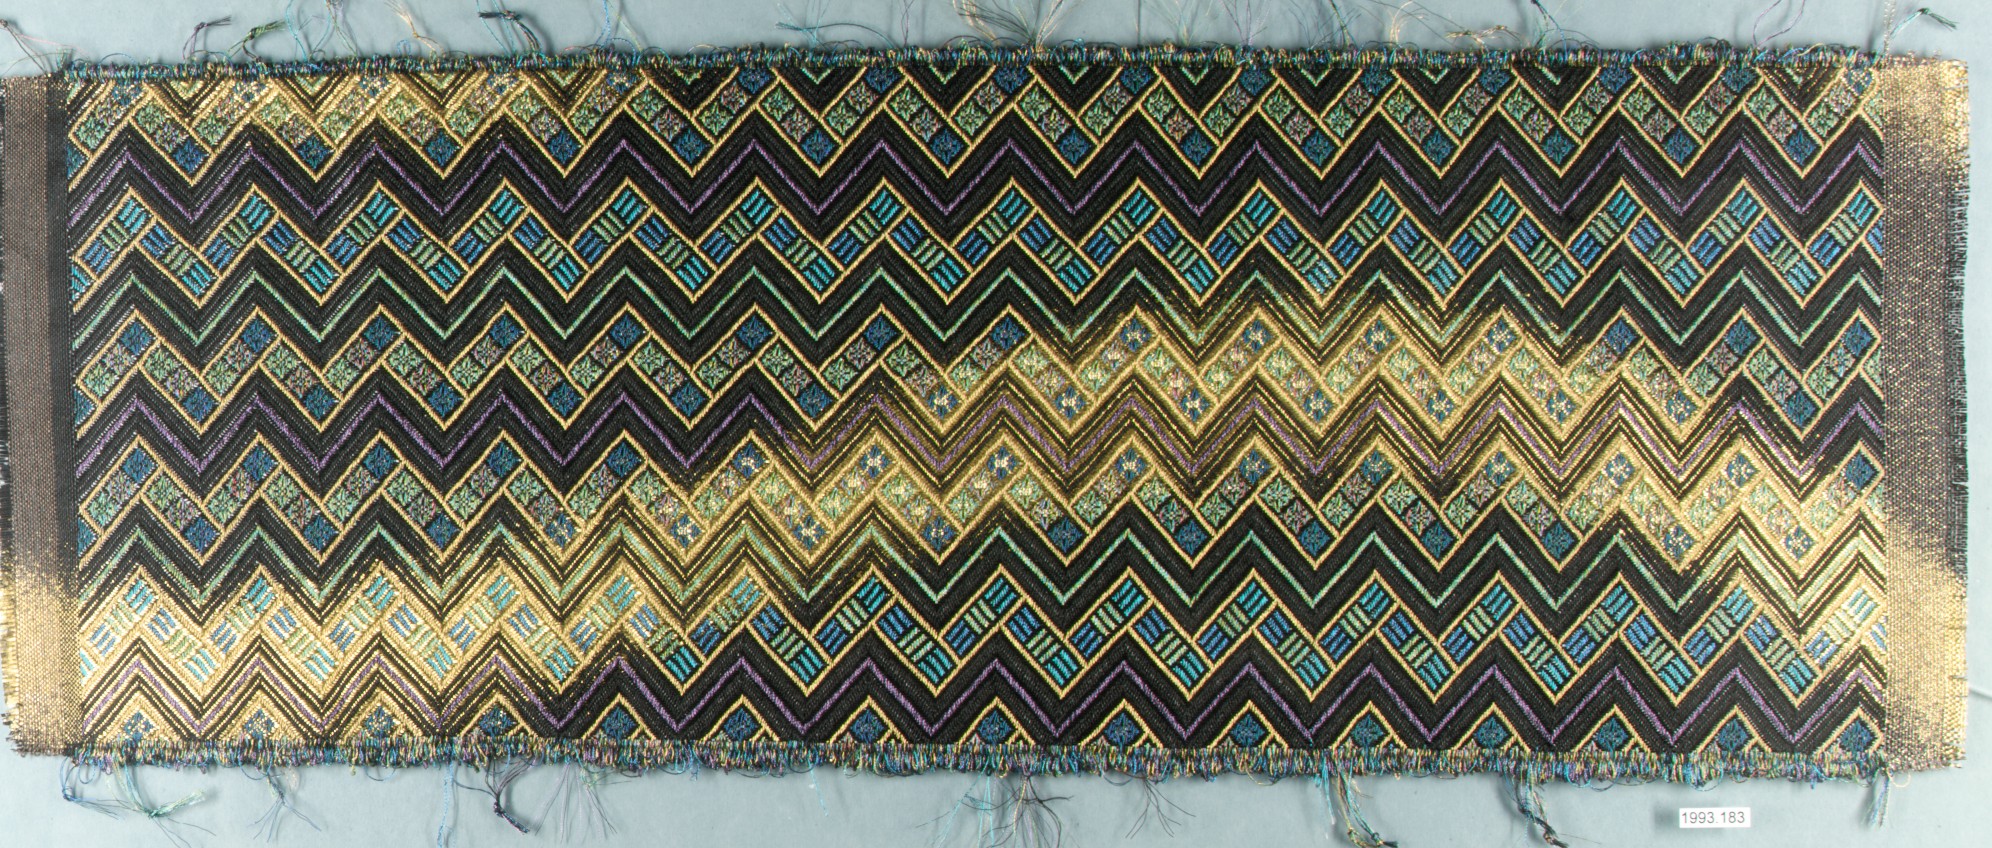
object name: woven tapestry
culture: japanese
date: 1901-2000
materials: fiber, gold, thread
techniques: lacquer